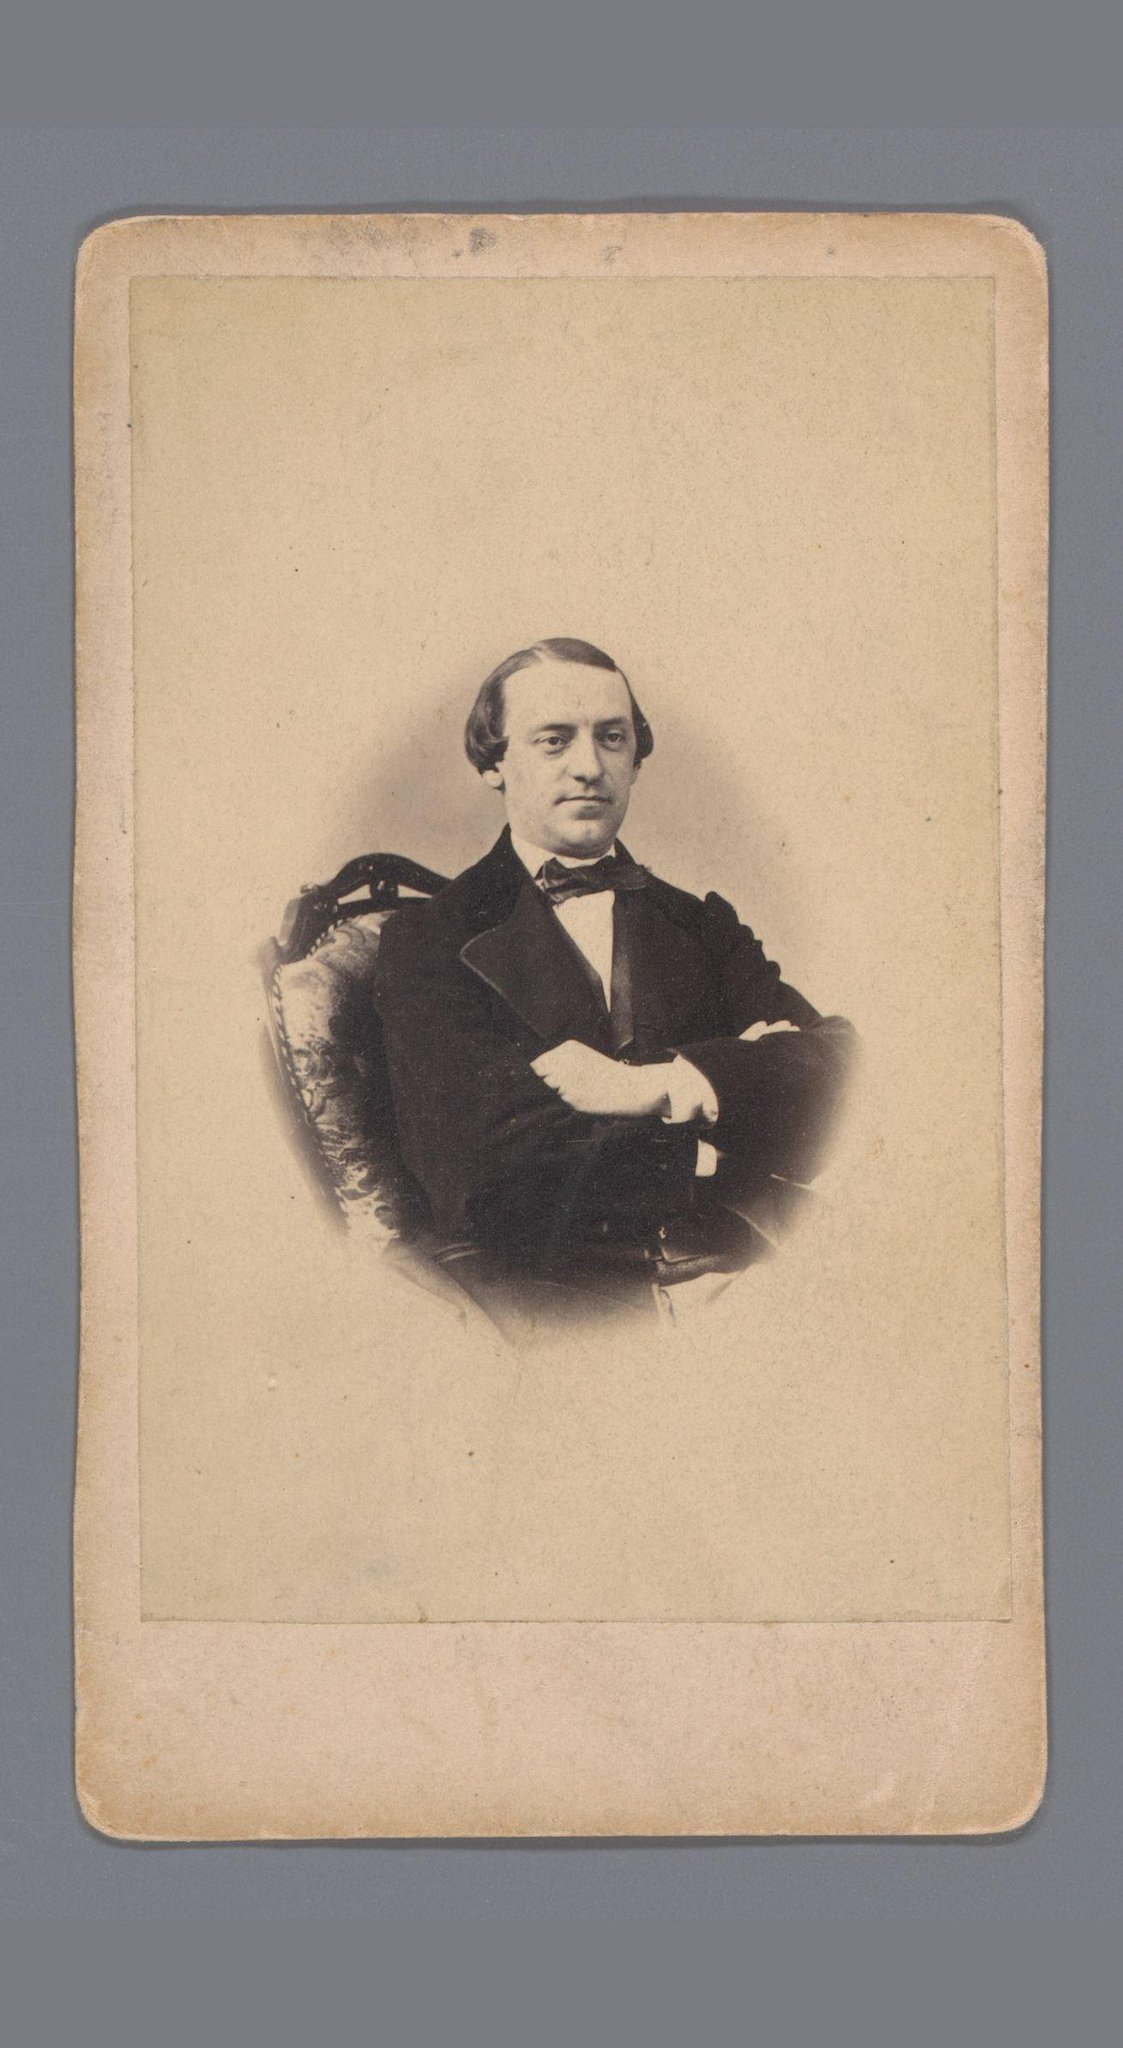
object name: carte de visite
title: Portret van een onbekende man met zijn armen over elkaar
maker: jacob lundbergh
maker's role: fotograaf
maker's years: 1828-1904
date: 1861-1871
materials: cardboard, paper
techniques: albumen print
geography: stockholm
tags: adult man, historical persons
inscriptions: inscription: ‘W5/ 050’, inscription: ‘J. LUNDBERGH/ FOTOGRAF/ Göthgatan/ No. 2. Urvädersgränd No. 2./ STOCKHOLM’, inscription: ‘[...]’